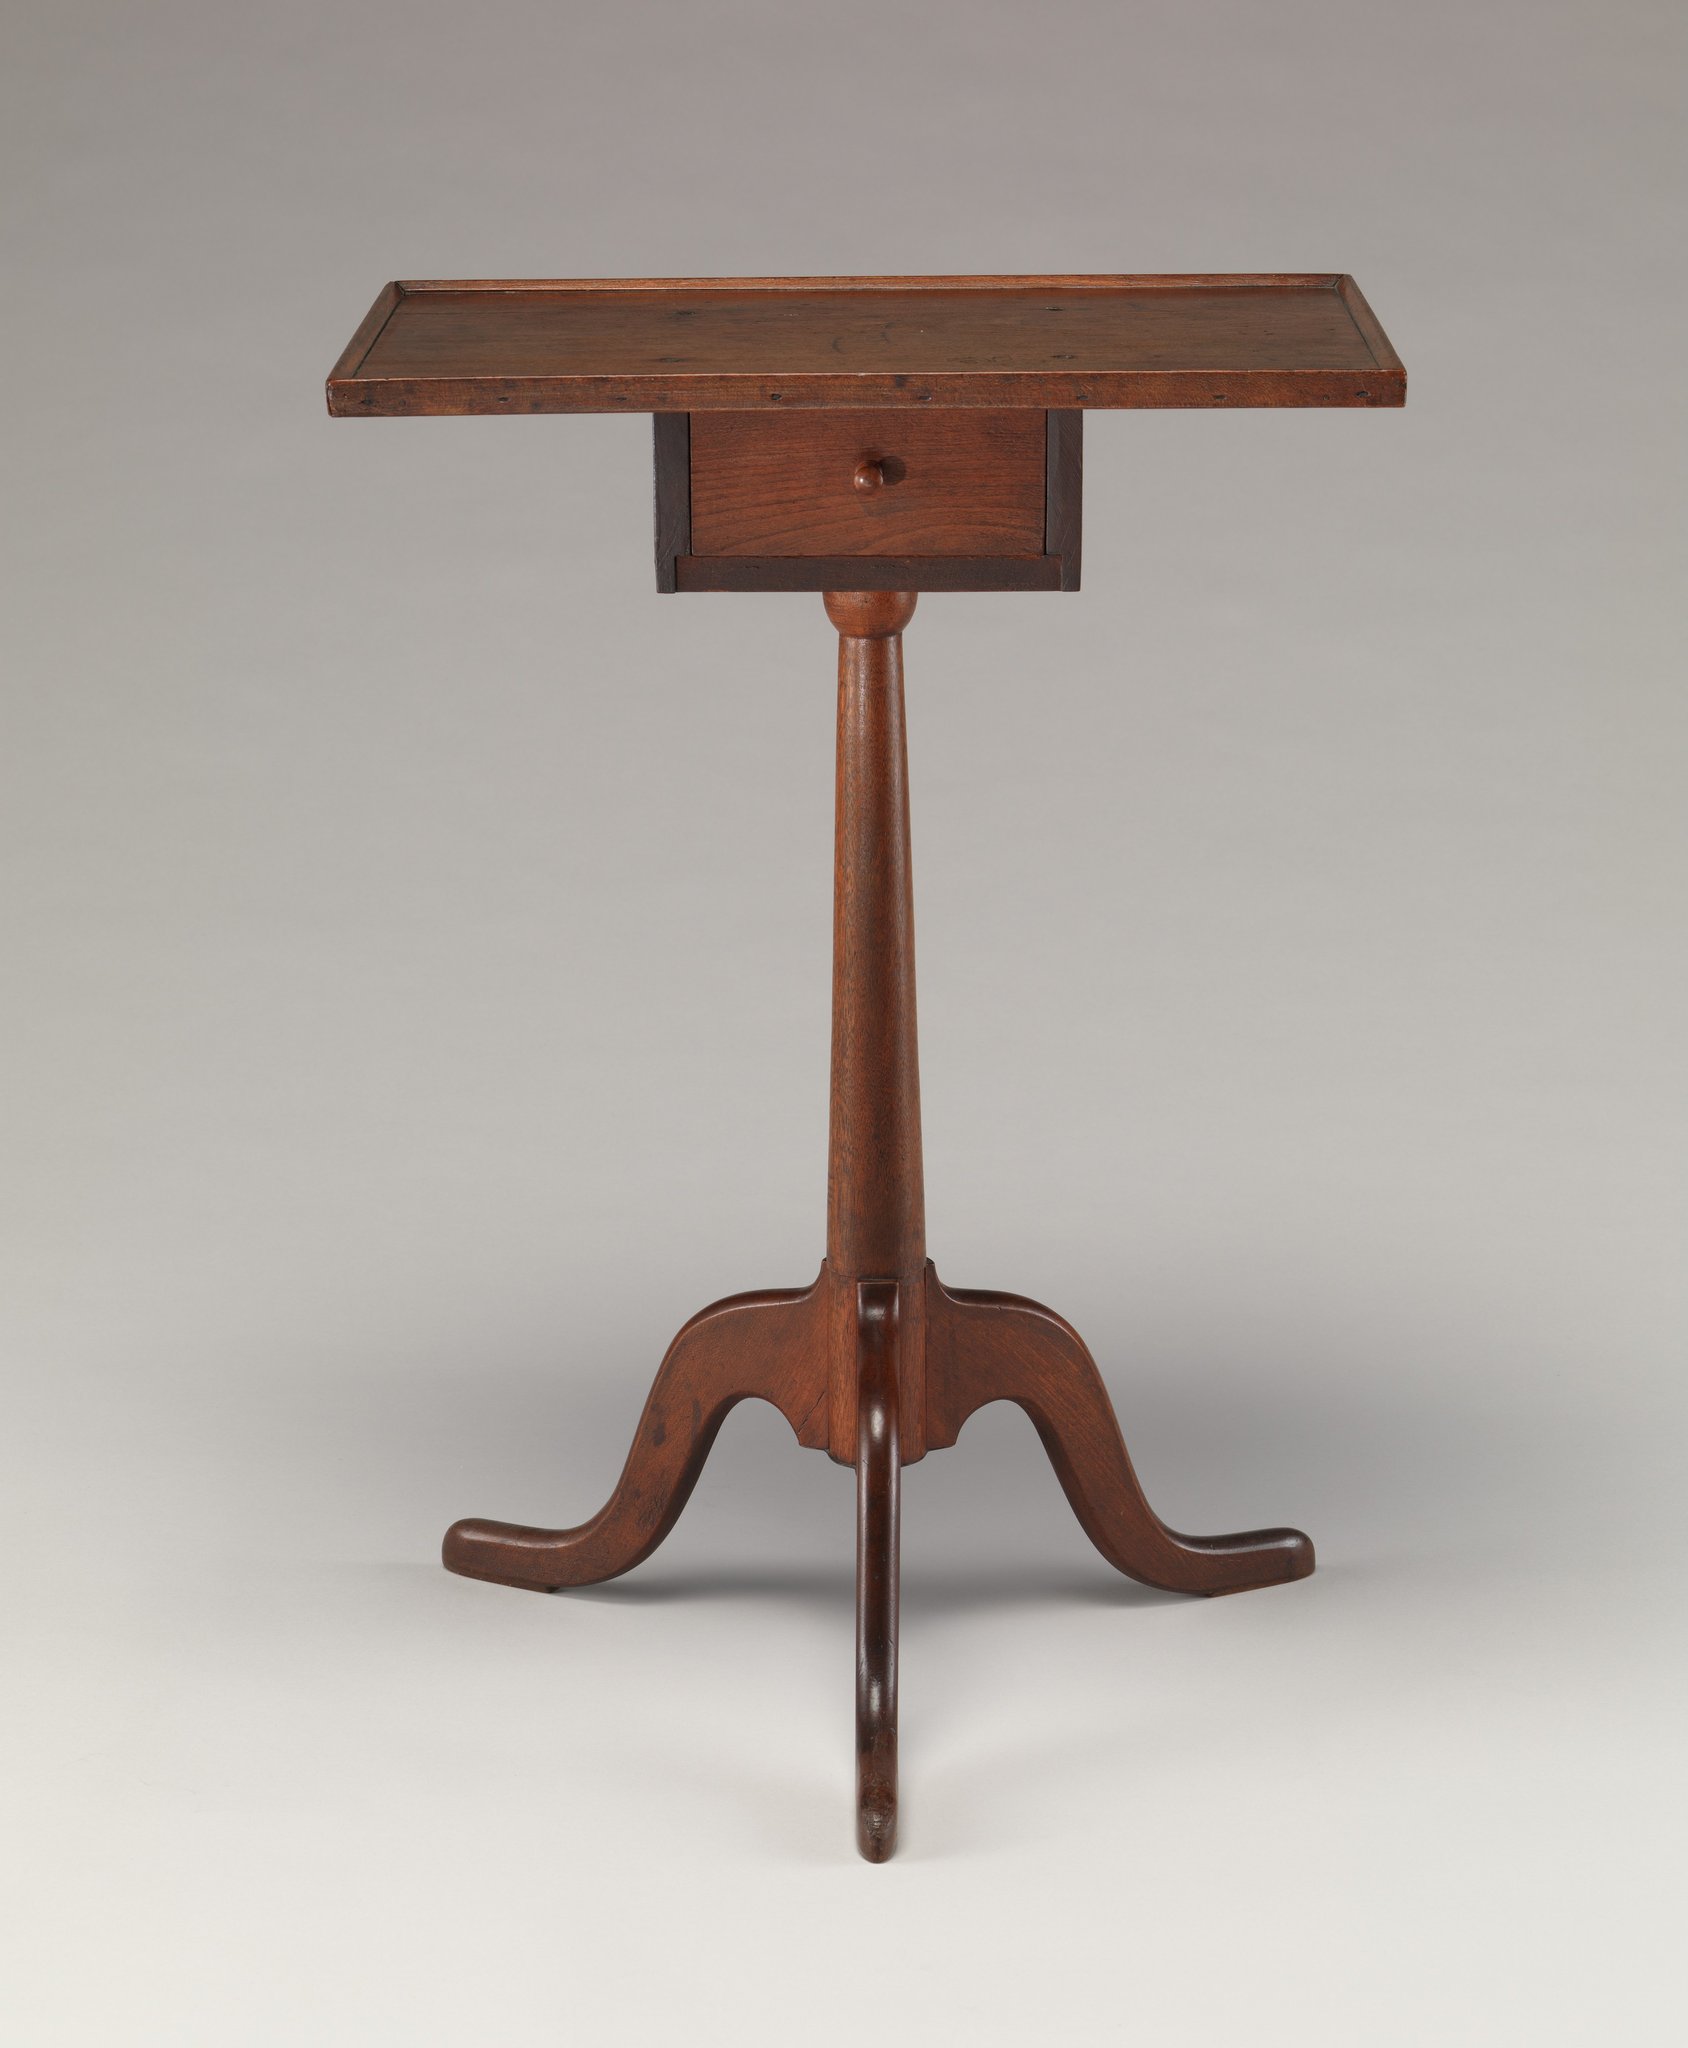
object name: candle stand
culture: american, shaker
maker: united society of believers in christ’s second appearing (“shakers”)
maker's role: maker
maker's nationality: american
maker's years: 1750-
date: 1800-1830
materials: wood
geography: united states